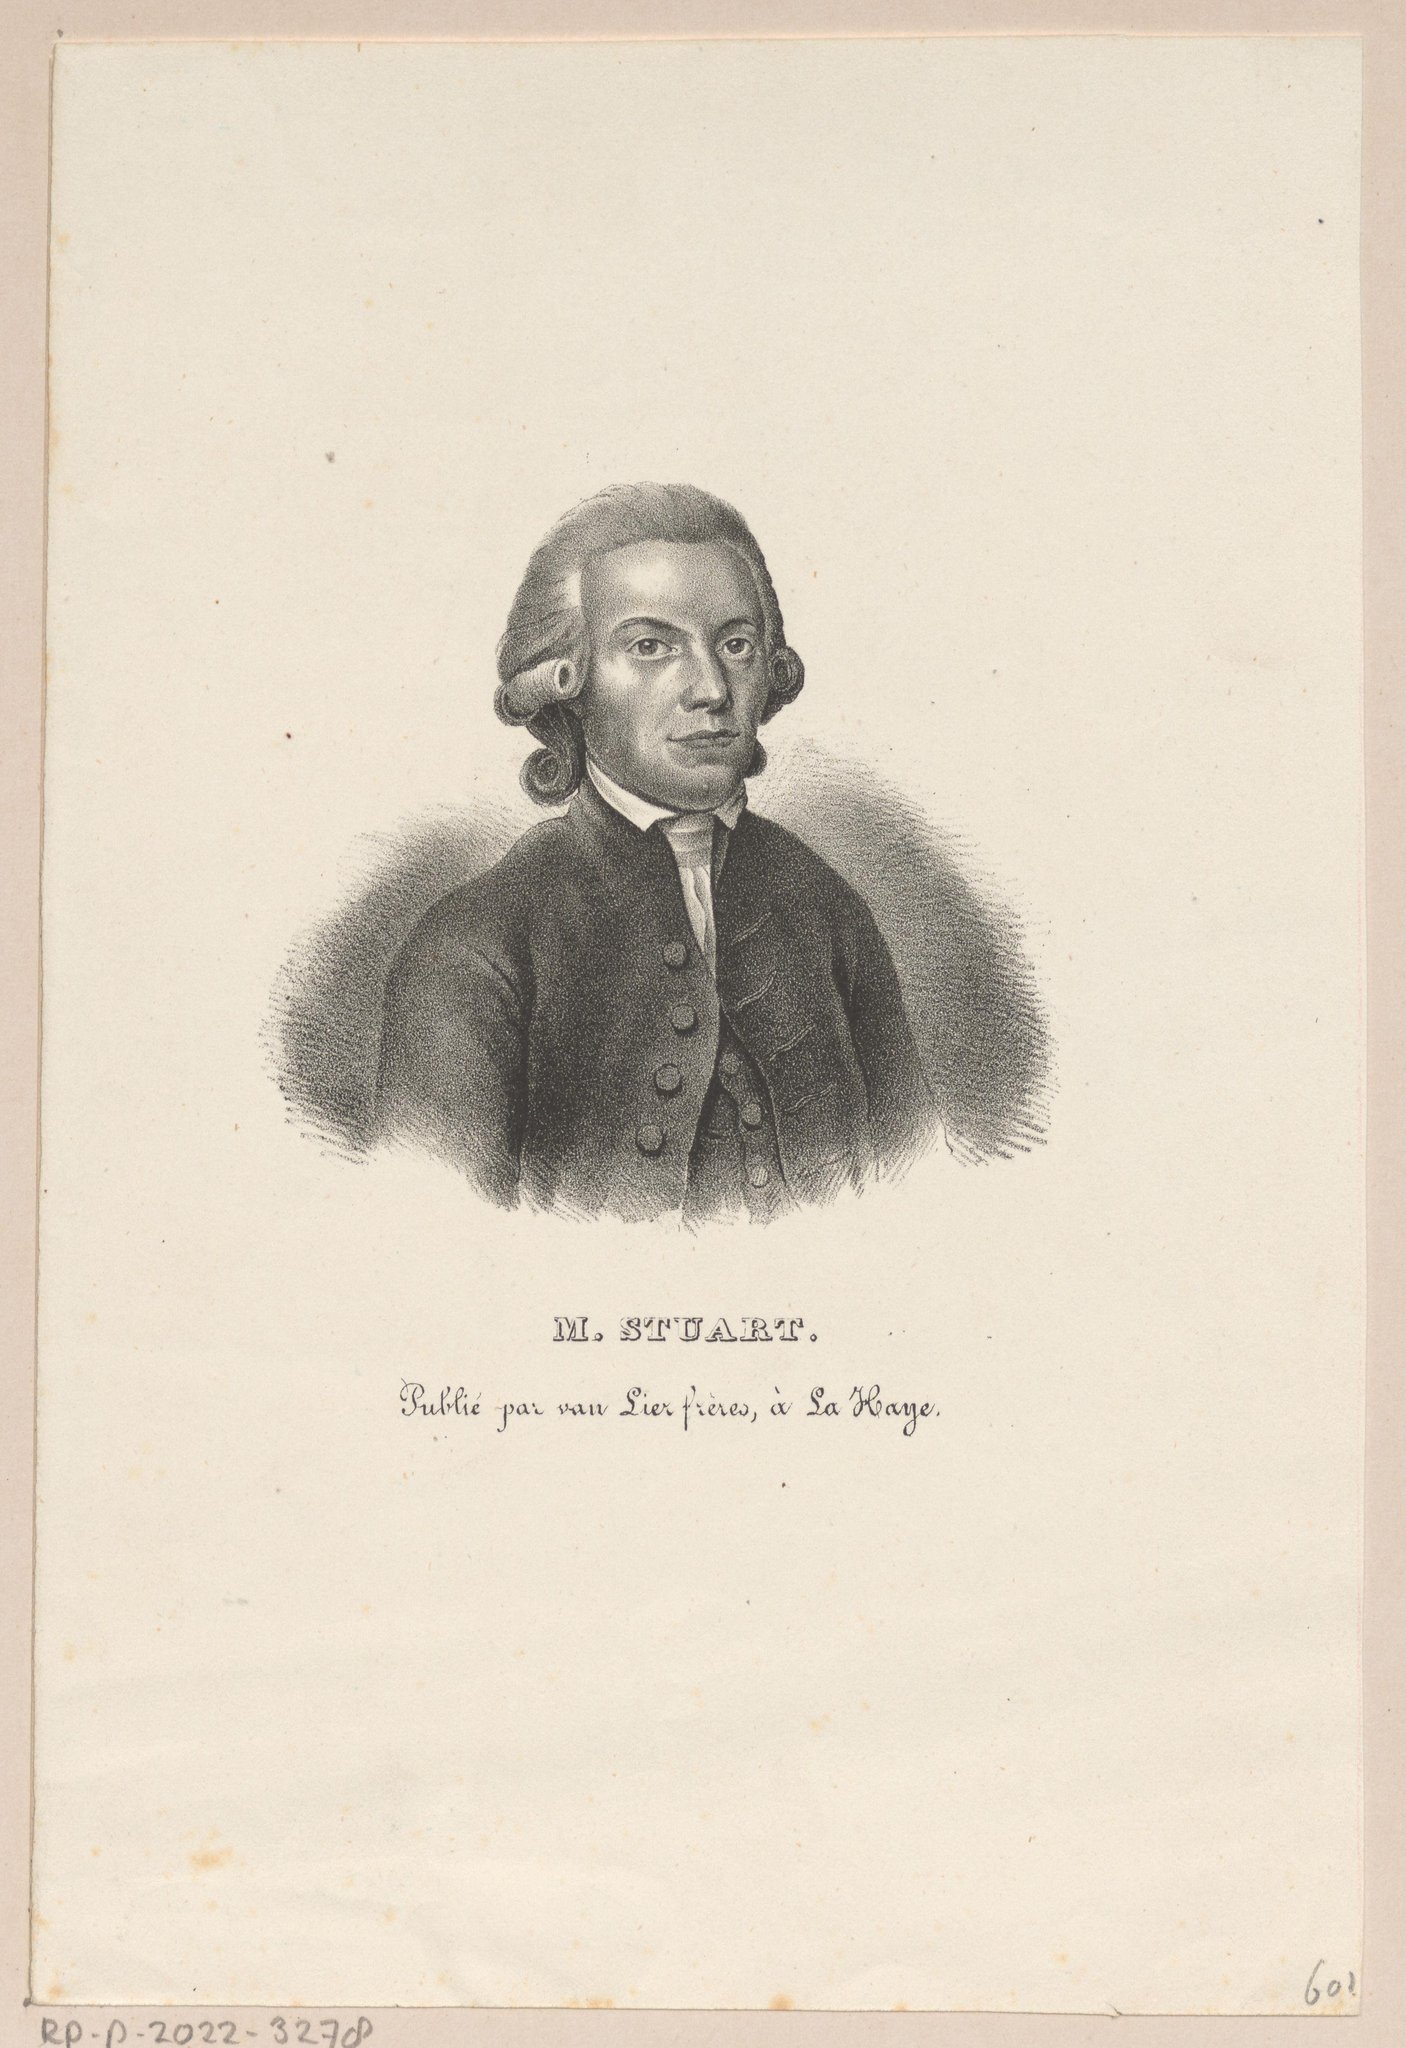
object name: print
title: Portret van Martinus Stuart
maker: Anonymous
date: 1837-1846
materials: paper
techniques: lithograph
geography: netherlands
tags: rotterdam, amsterdam, historical persons, portrait of a writer